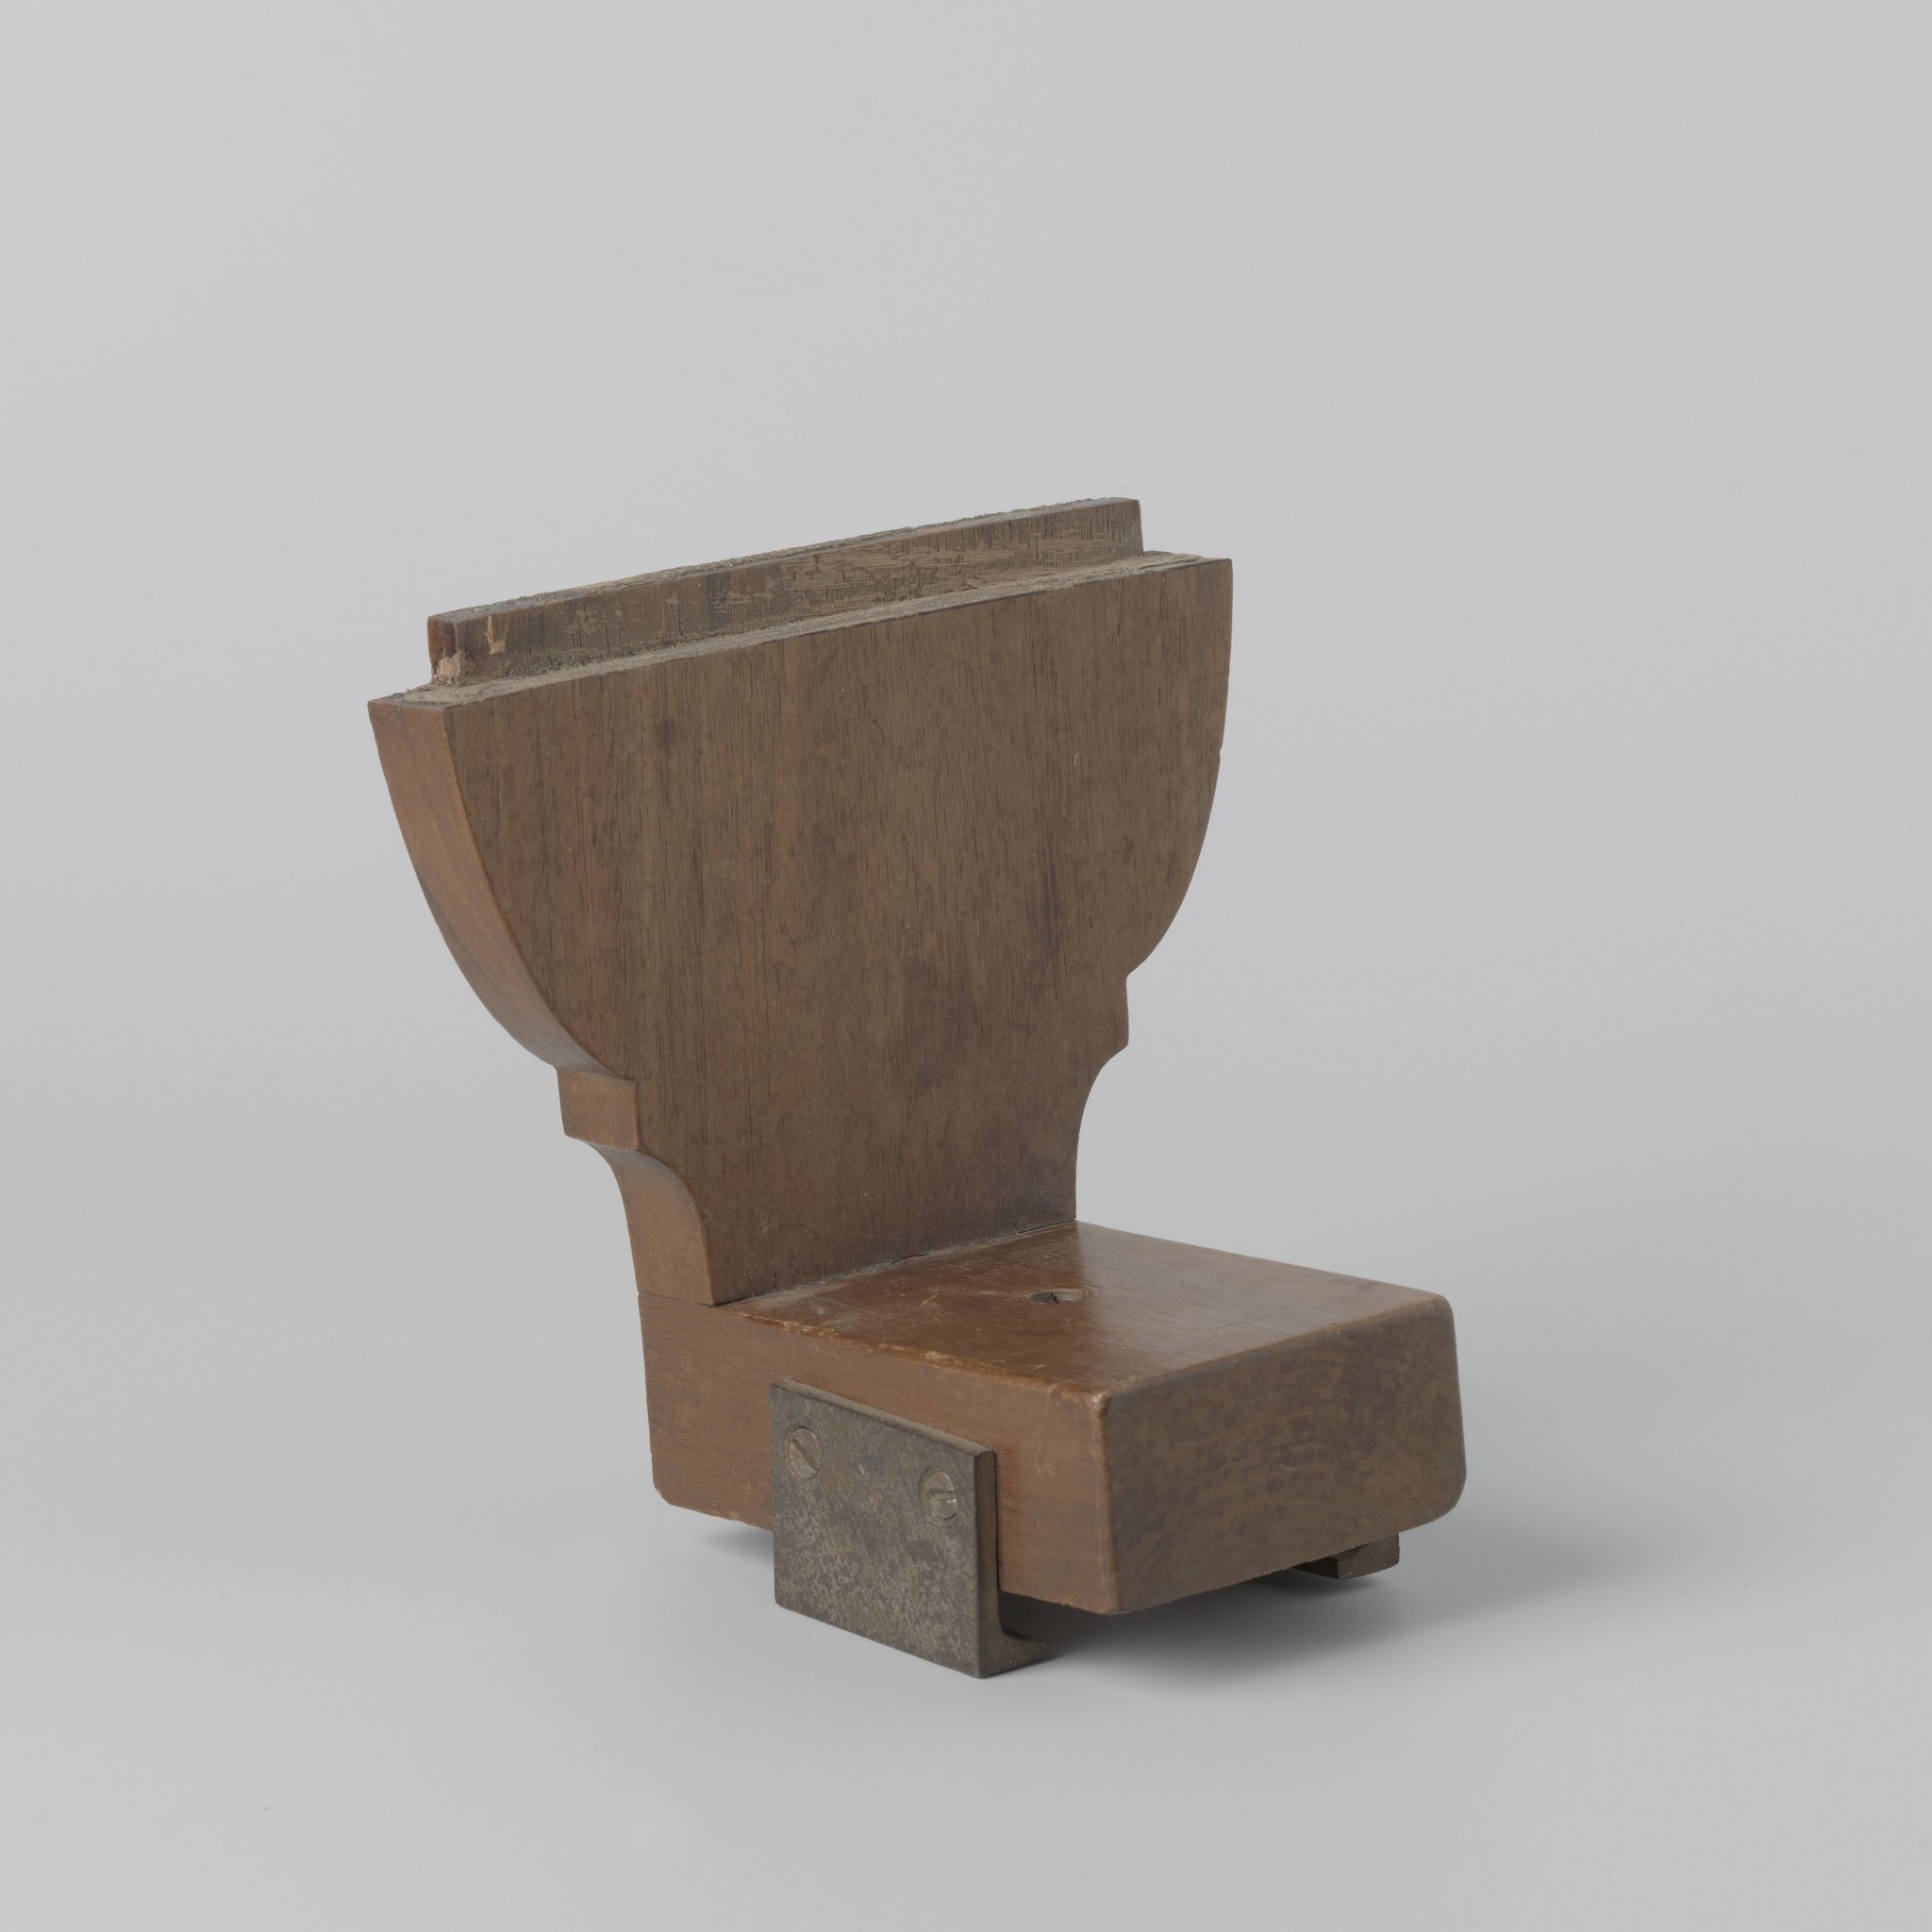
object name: artifact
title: Houder?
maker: Anonymous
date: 1850-1900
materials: metal, wood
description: Houder, incompleet, bestaand uit twee houten planken die in een hoek van 90 graden aan elkaar zijn bevestigd. Ene plankje is rechthoekig en bevat een gat in het midden en twee metalen klemmen aan beide zijden, de andere plank loopt breed uit. De functie van dit object is onbekend.